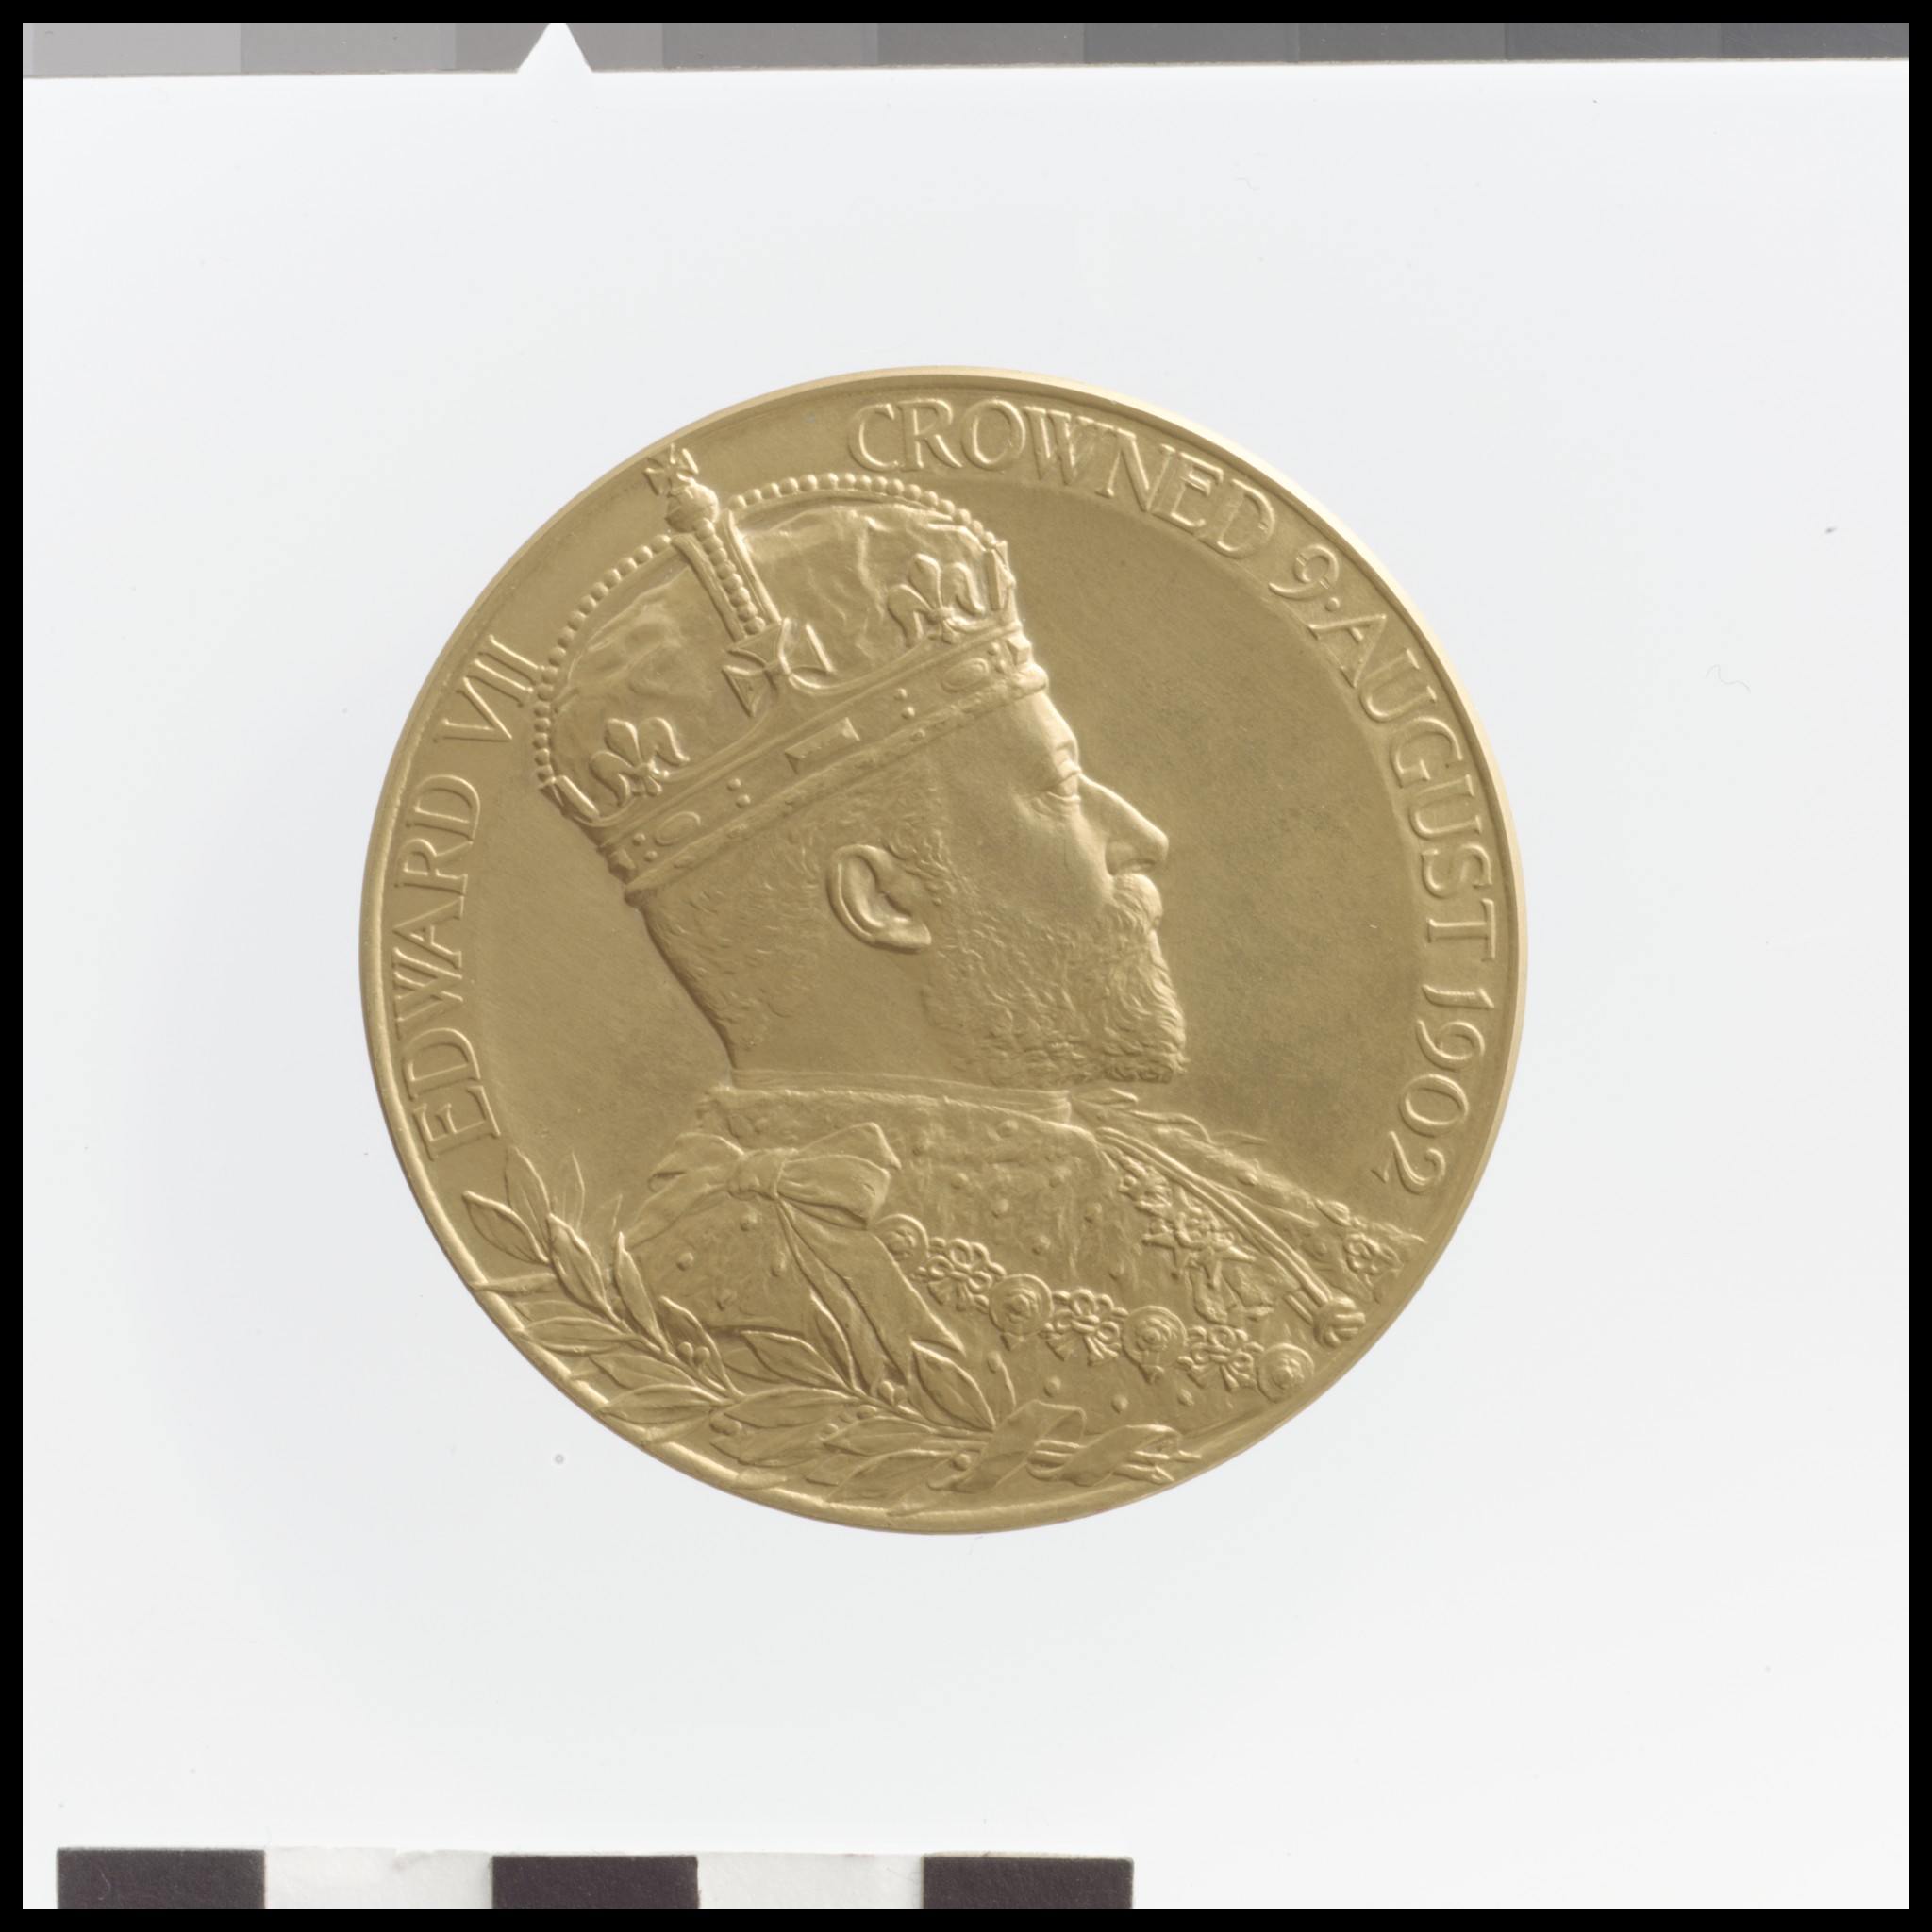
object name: medal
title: Edward VII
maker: g.w. desaulles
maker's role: artist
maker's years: 1862-1903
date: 1902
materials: gold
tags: kings,profiles,flowers